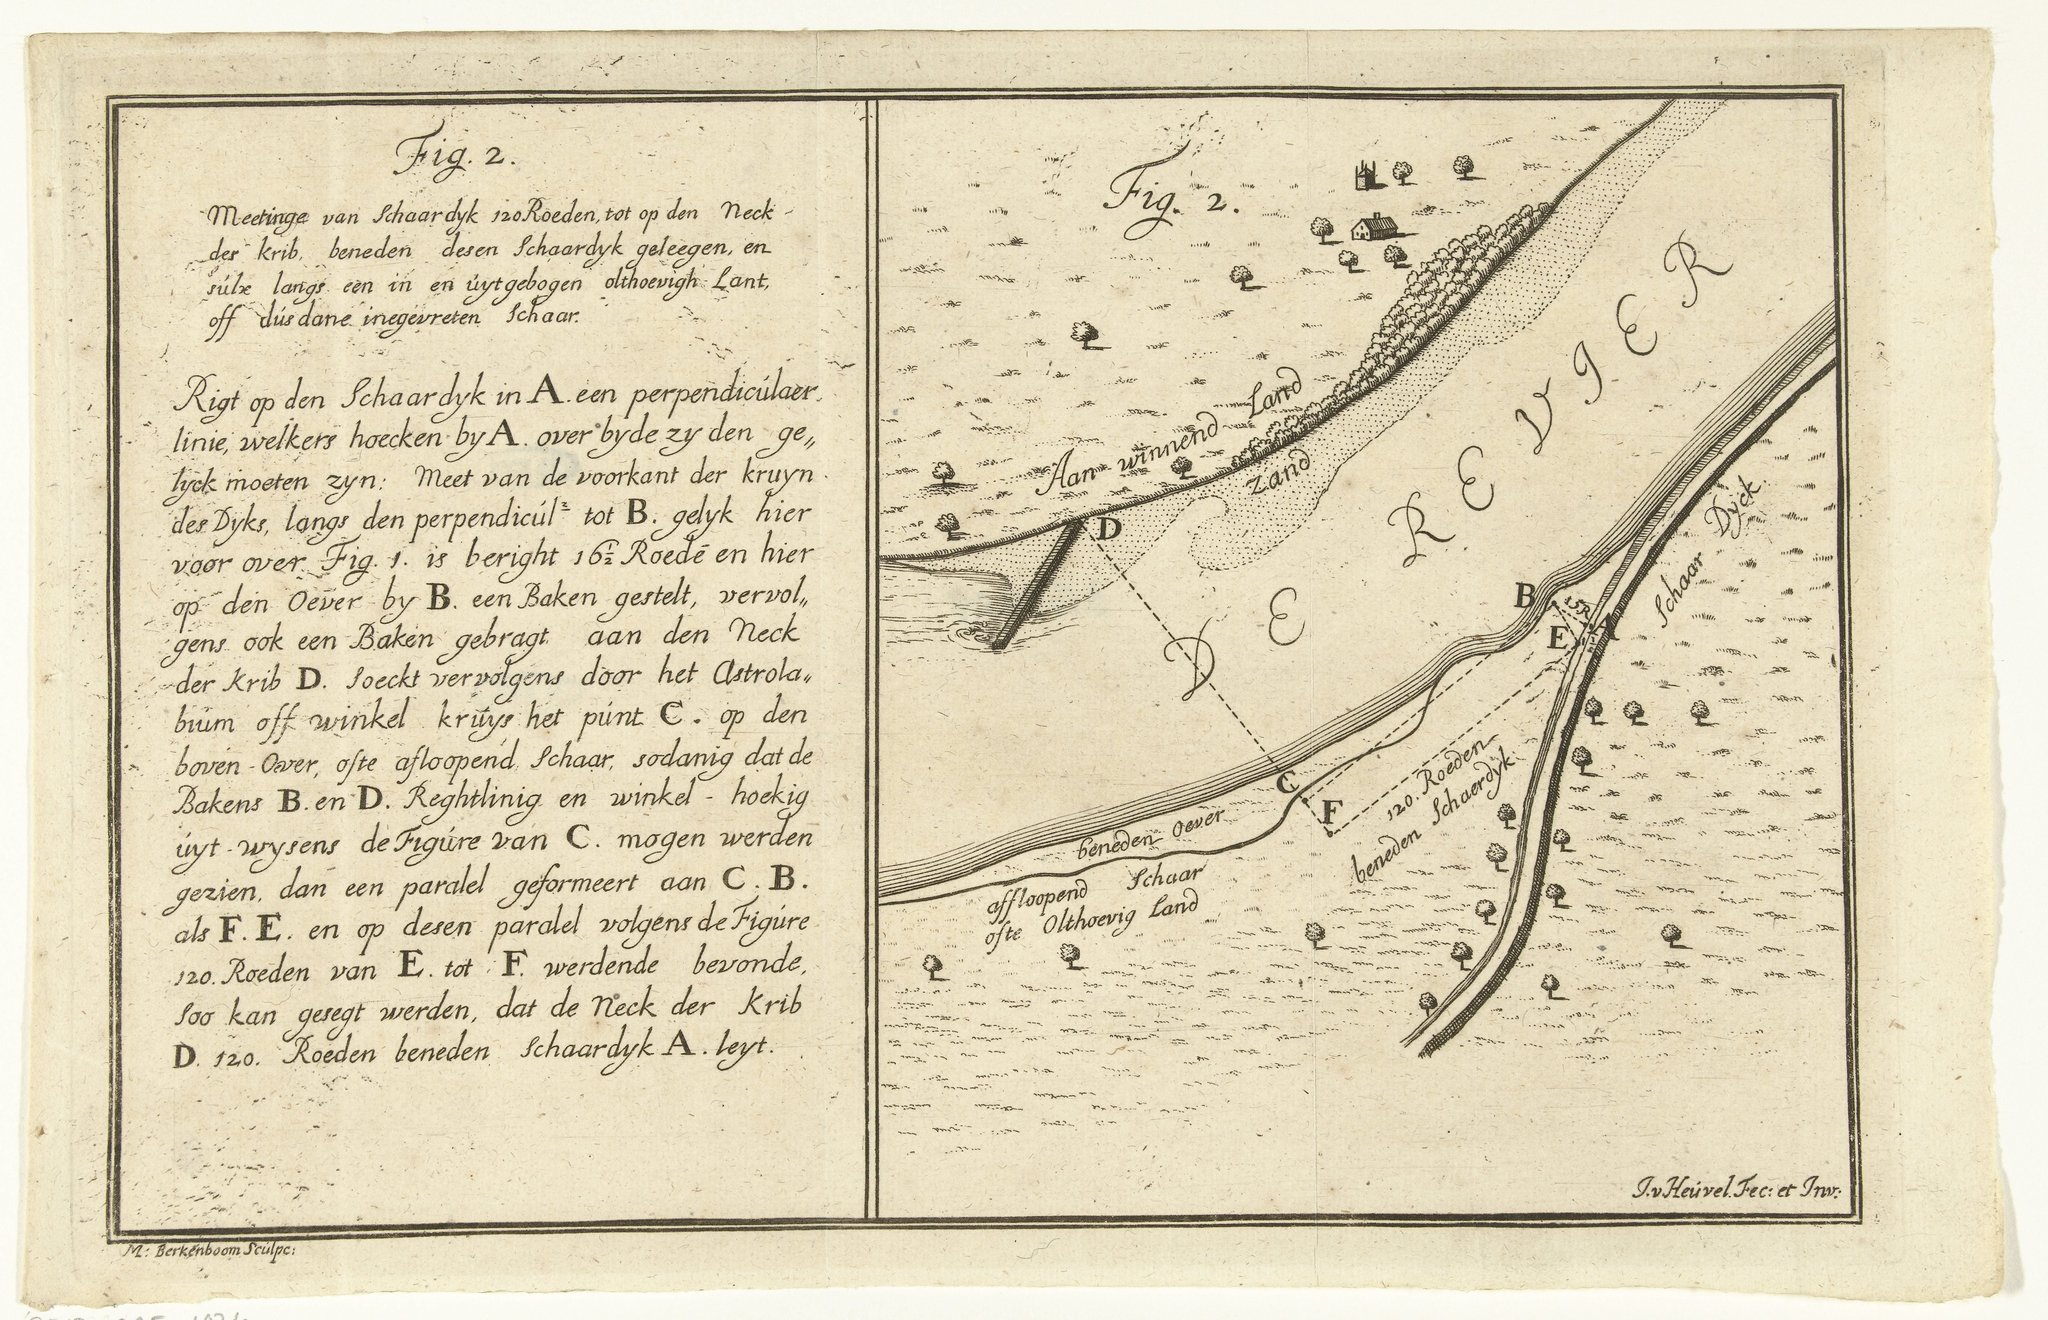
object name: print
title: Plattegronden van rivieren, kanalen en polders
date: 1650-1715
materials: paper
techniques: etching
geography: nijmegen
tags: swamps and polders, dikes, levee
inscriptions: collector's mark: Lugt 2760, collector's mark: Lugt 2228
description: Plattegrond van een bocht in een serpenterende rivier. Links een legenda van A-M. Prent maakt deel uit van een serie prenten over waterbouwkunde en inpoldering.